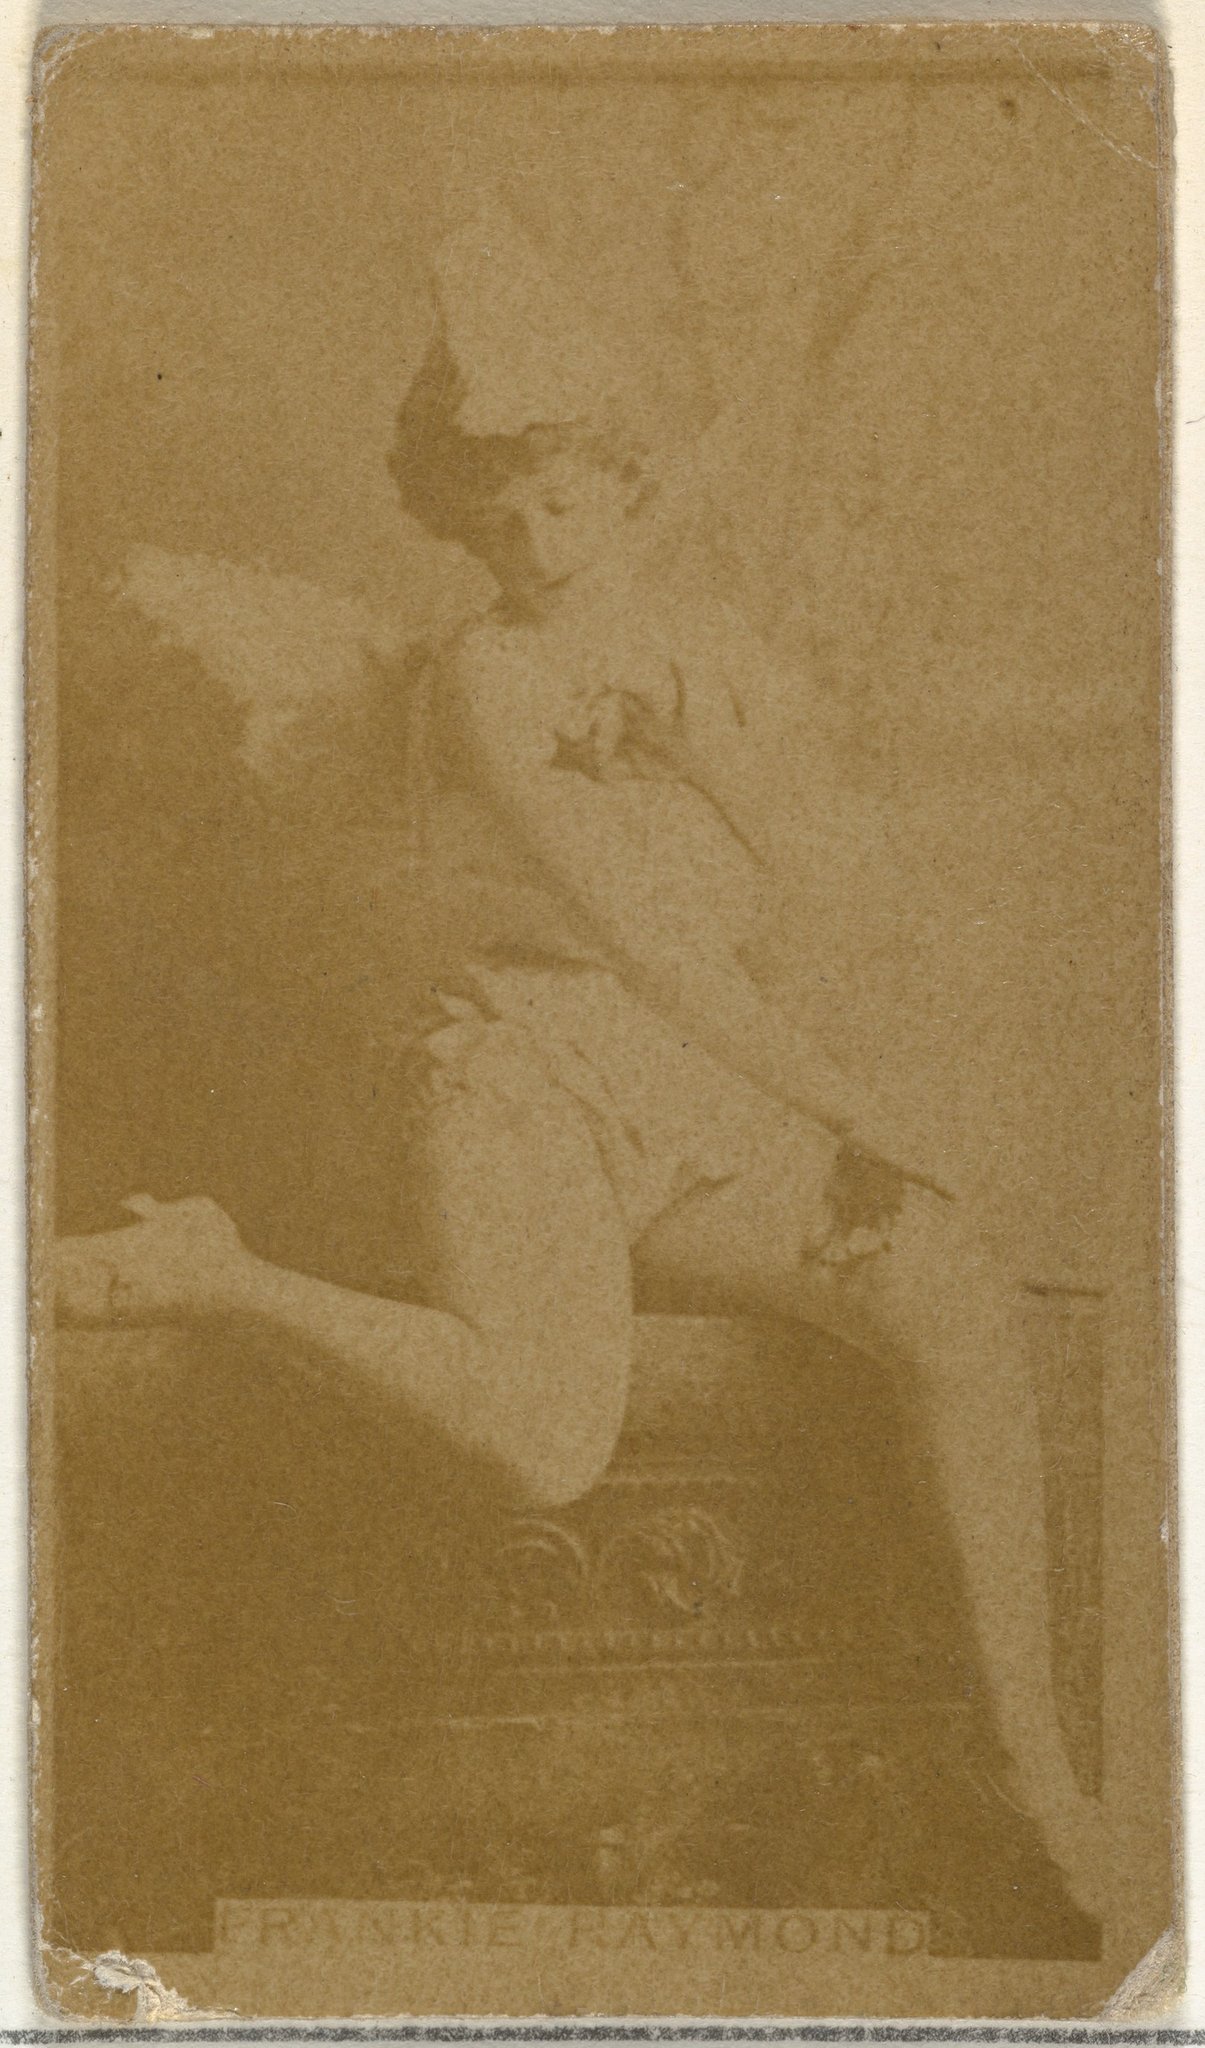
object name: photograph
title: Frankie Raymond, from the Actors and Actresses series (N145-8) issued by Duke Sons & Co. to promote Duke Cigarettes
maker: w. duke, sons & co.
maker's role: publisher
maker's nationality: american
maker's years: 1870-1920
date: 1891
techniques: albumen silver print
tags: portraits,women,actresses